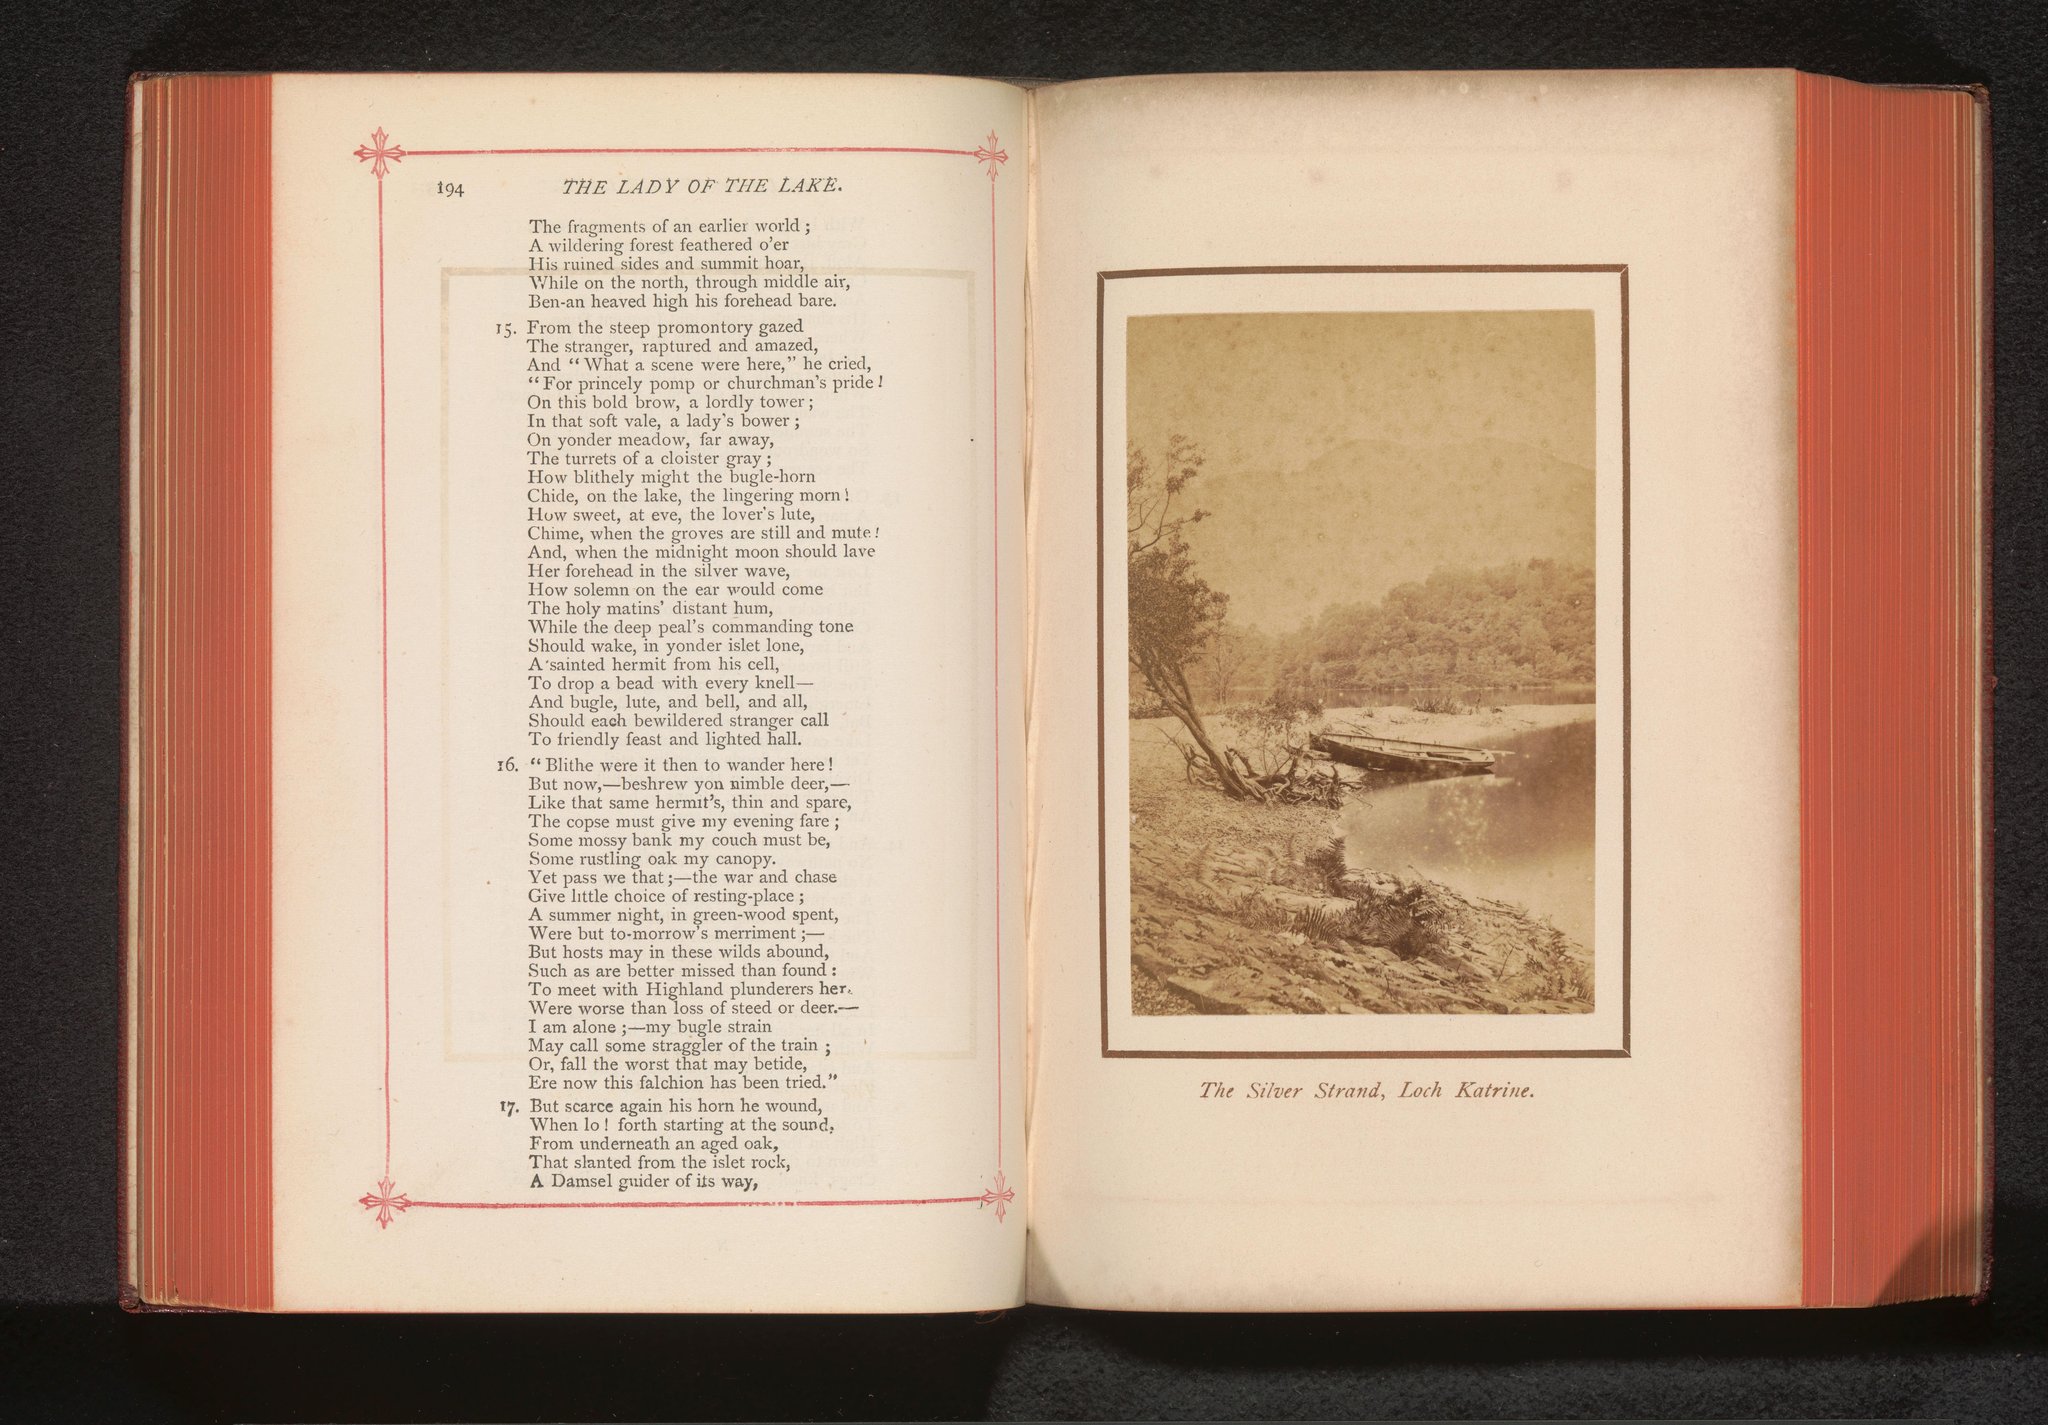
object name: page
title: The Silver Strand, Loch Katrine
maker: george washington wilson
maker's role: publisher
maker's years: 1823-1893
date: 1885-1890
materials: photographic support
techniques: albumen print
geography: scotland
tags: lake, ships, boats on land, beached